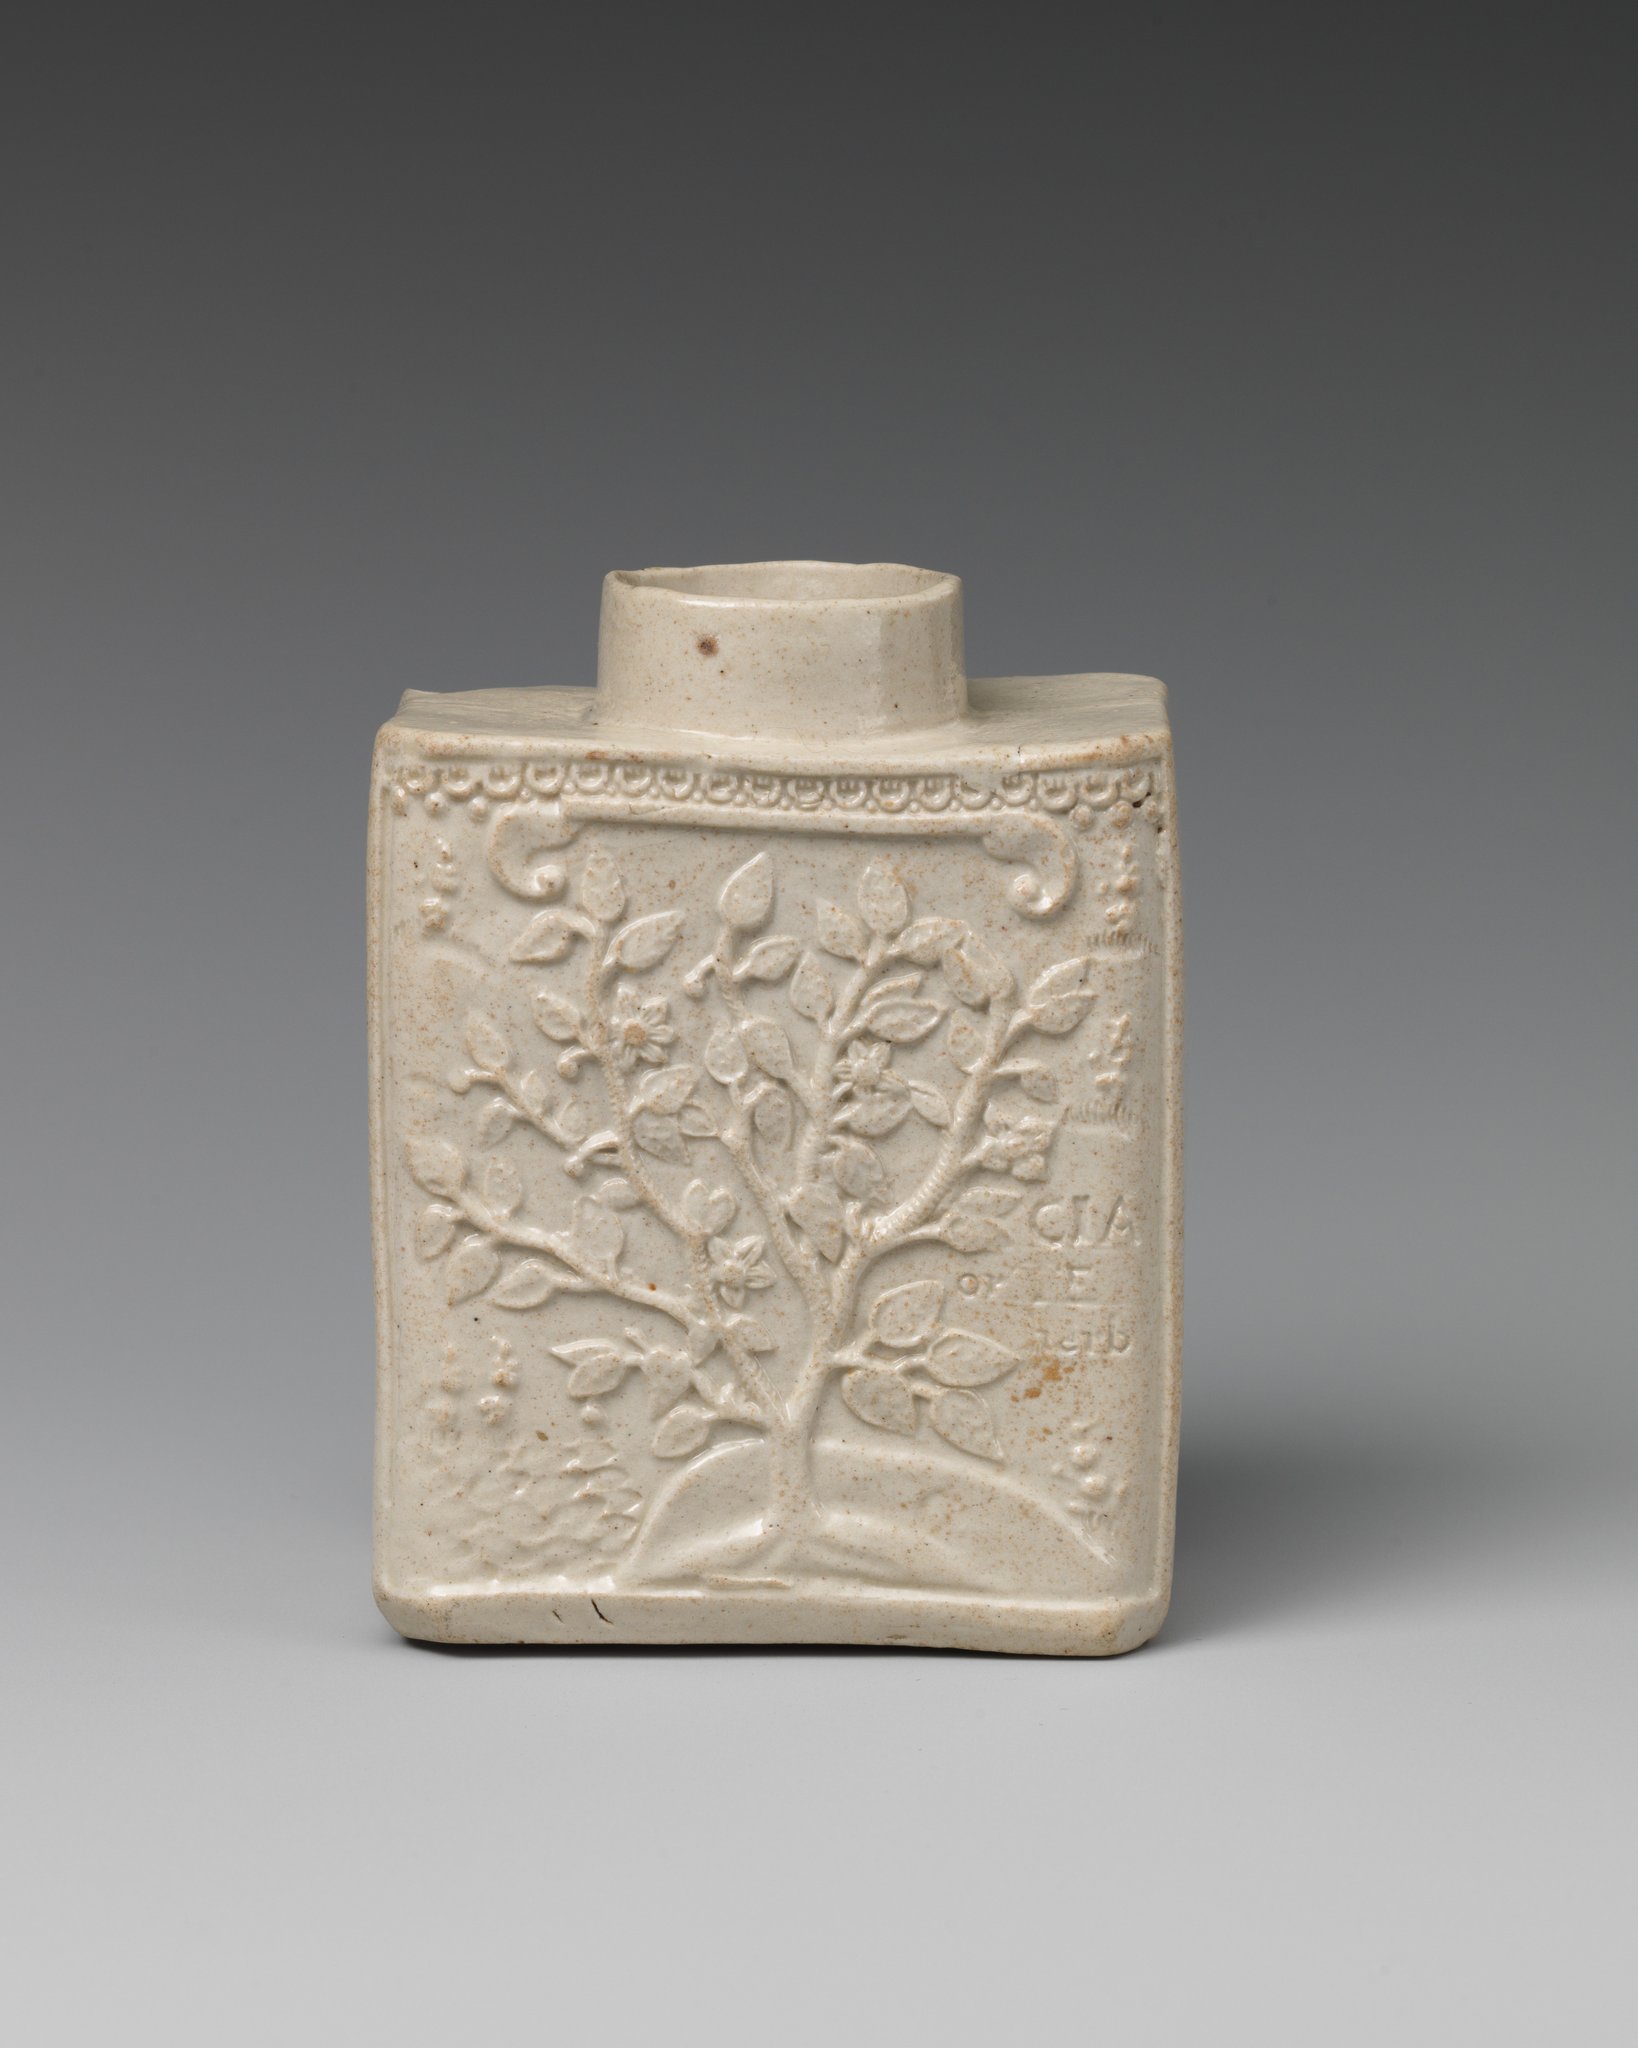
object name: tea caddy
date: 1740-1750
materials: stoneware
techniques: salt glaze